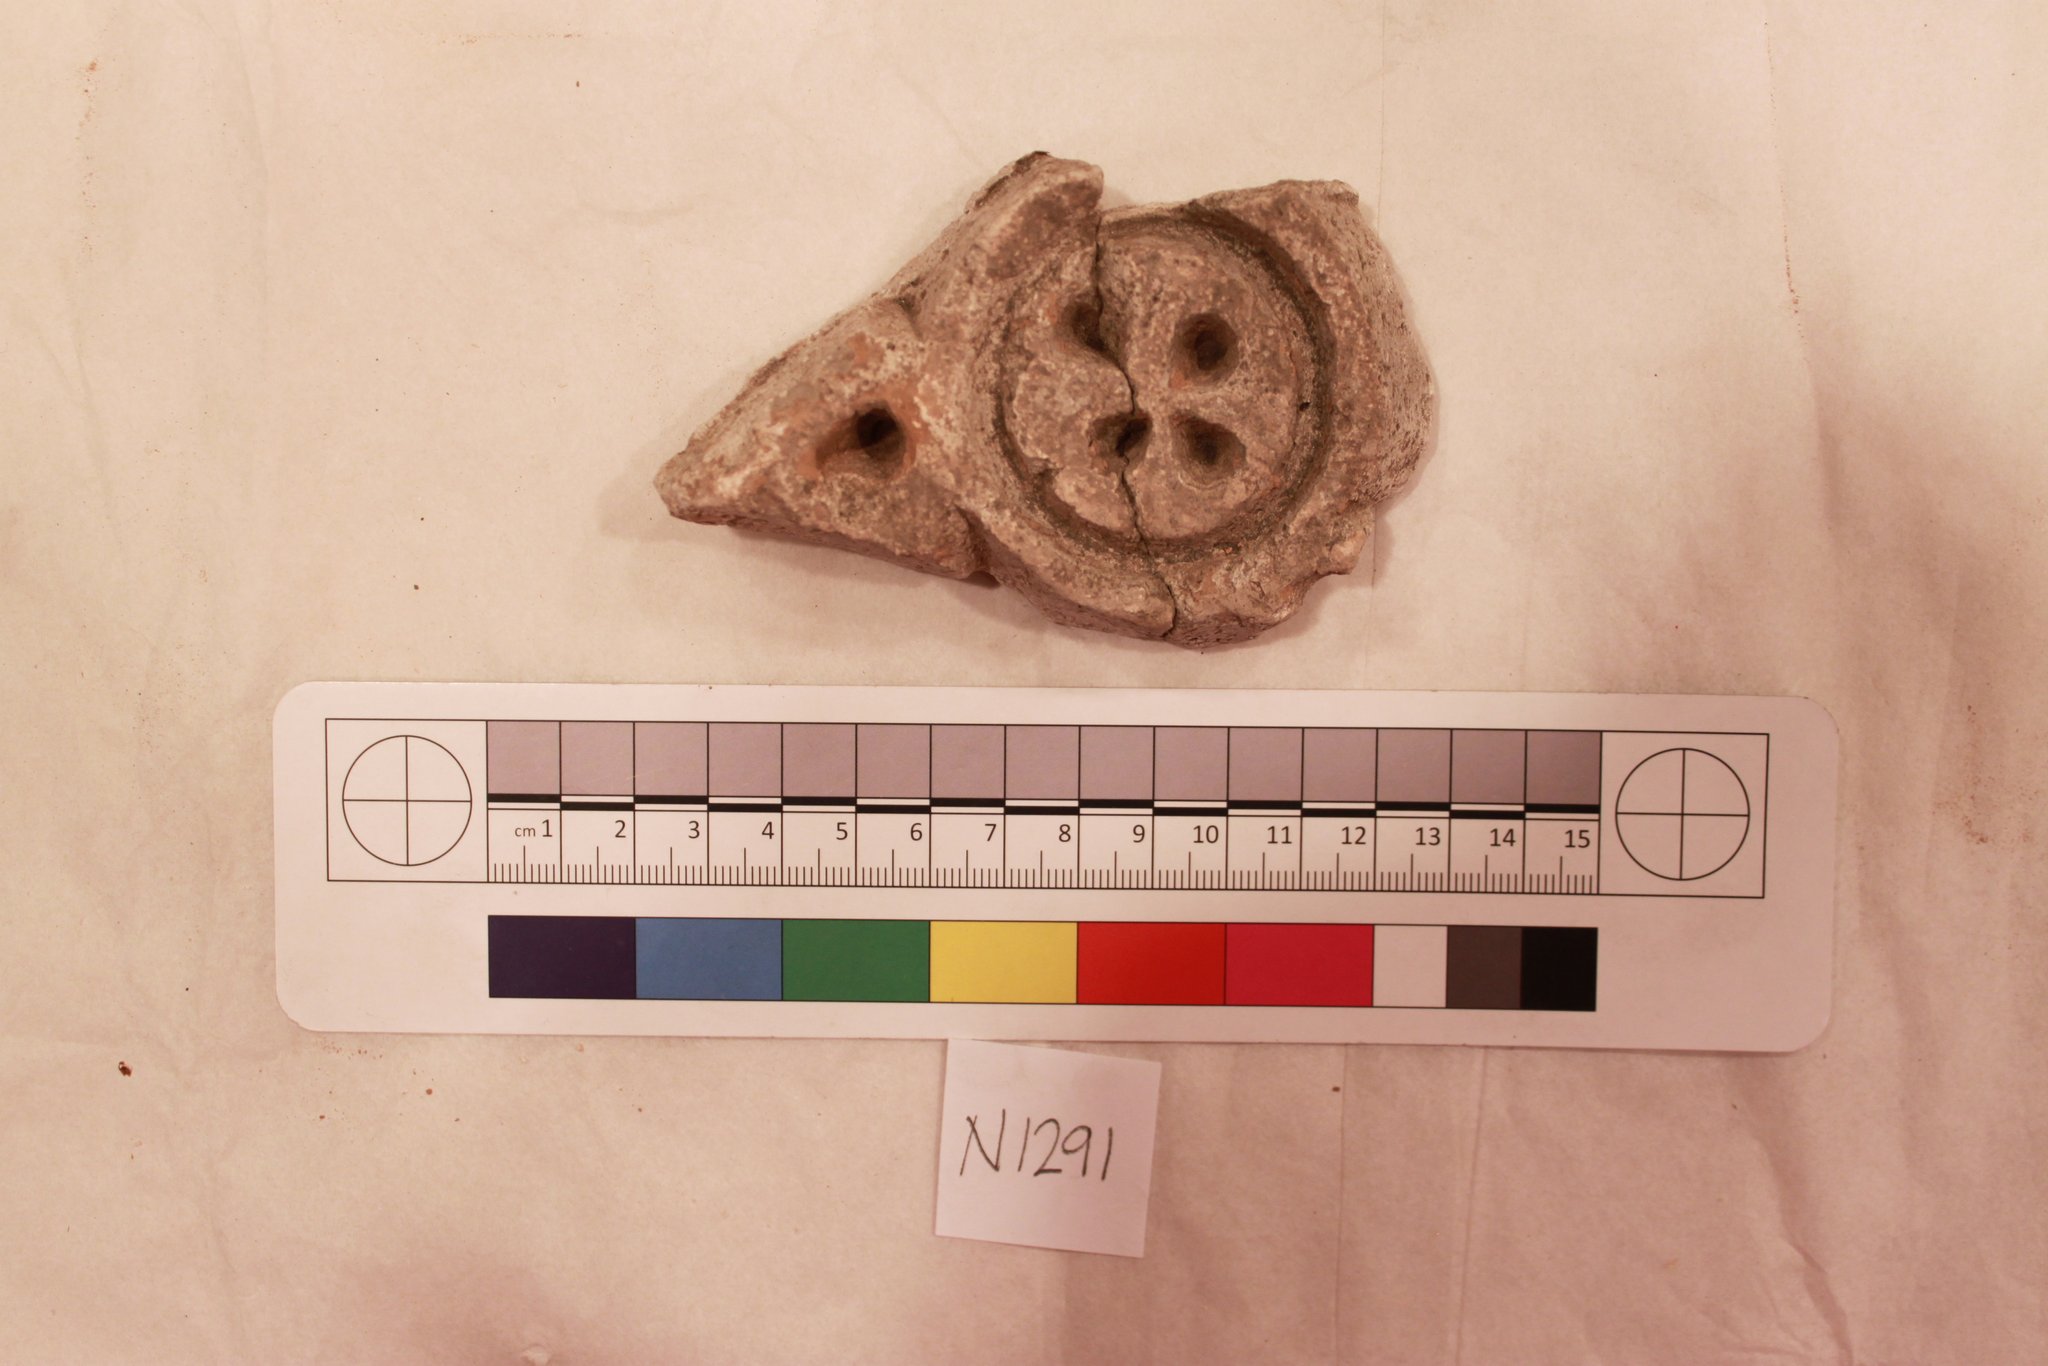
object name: fragment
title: Stucco Fragment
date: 701-1200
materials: plaster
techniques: carving, painting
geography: iran